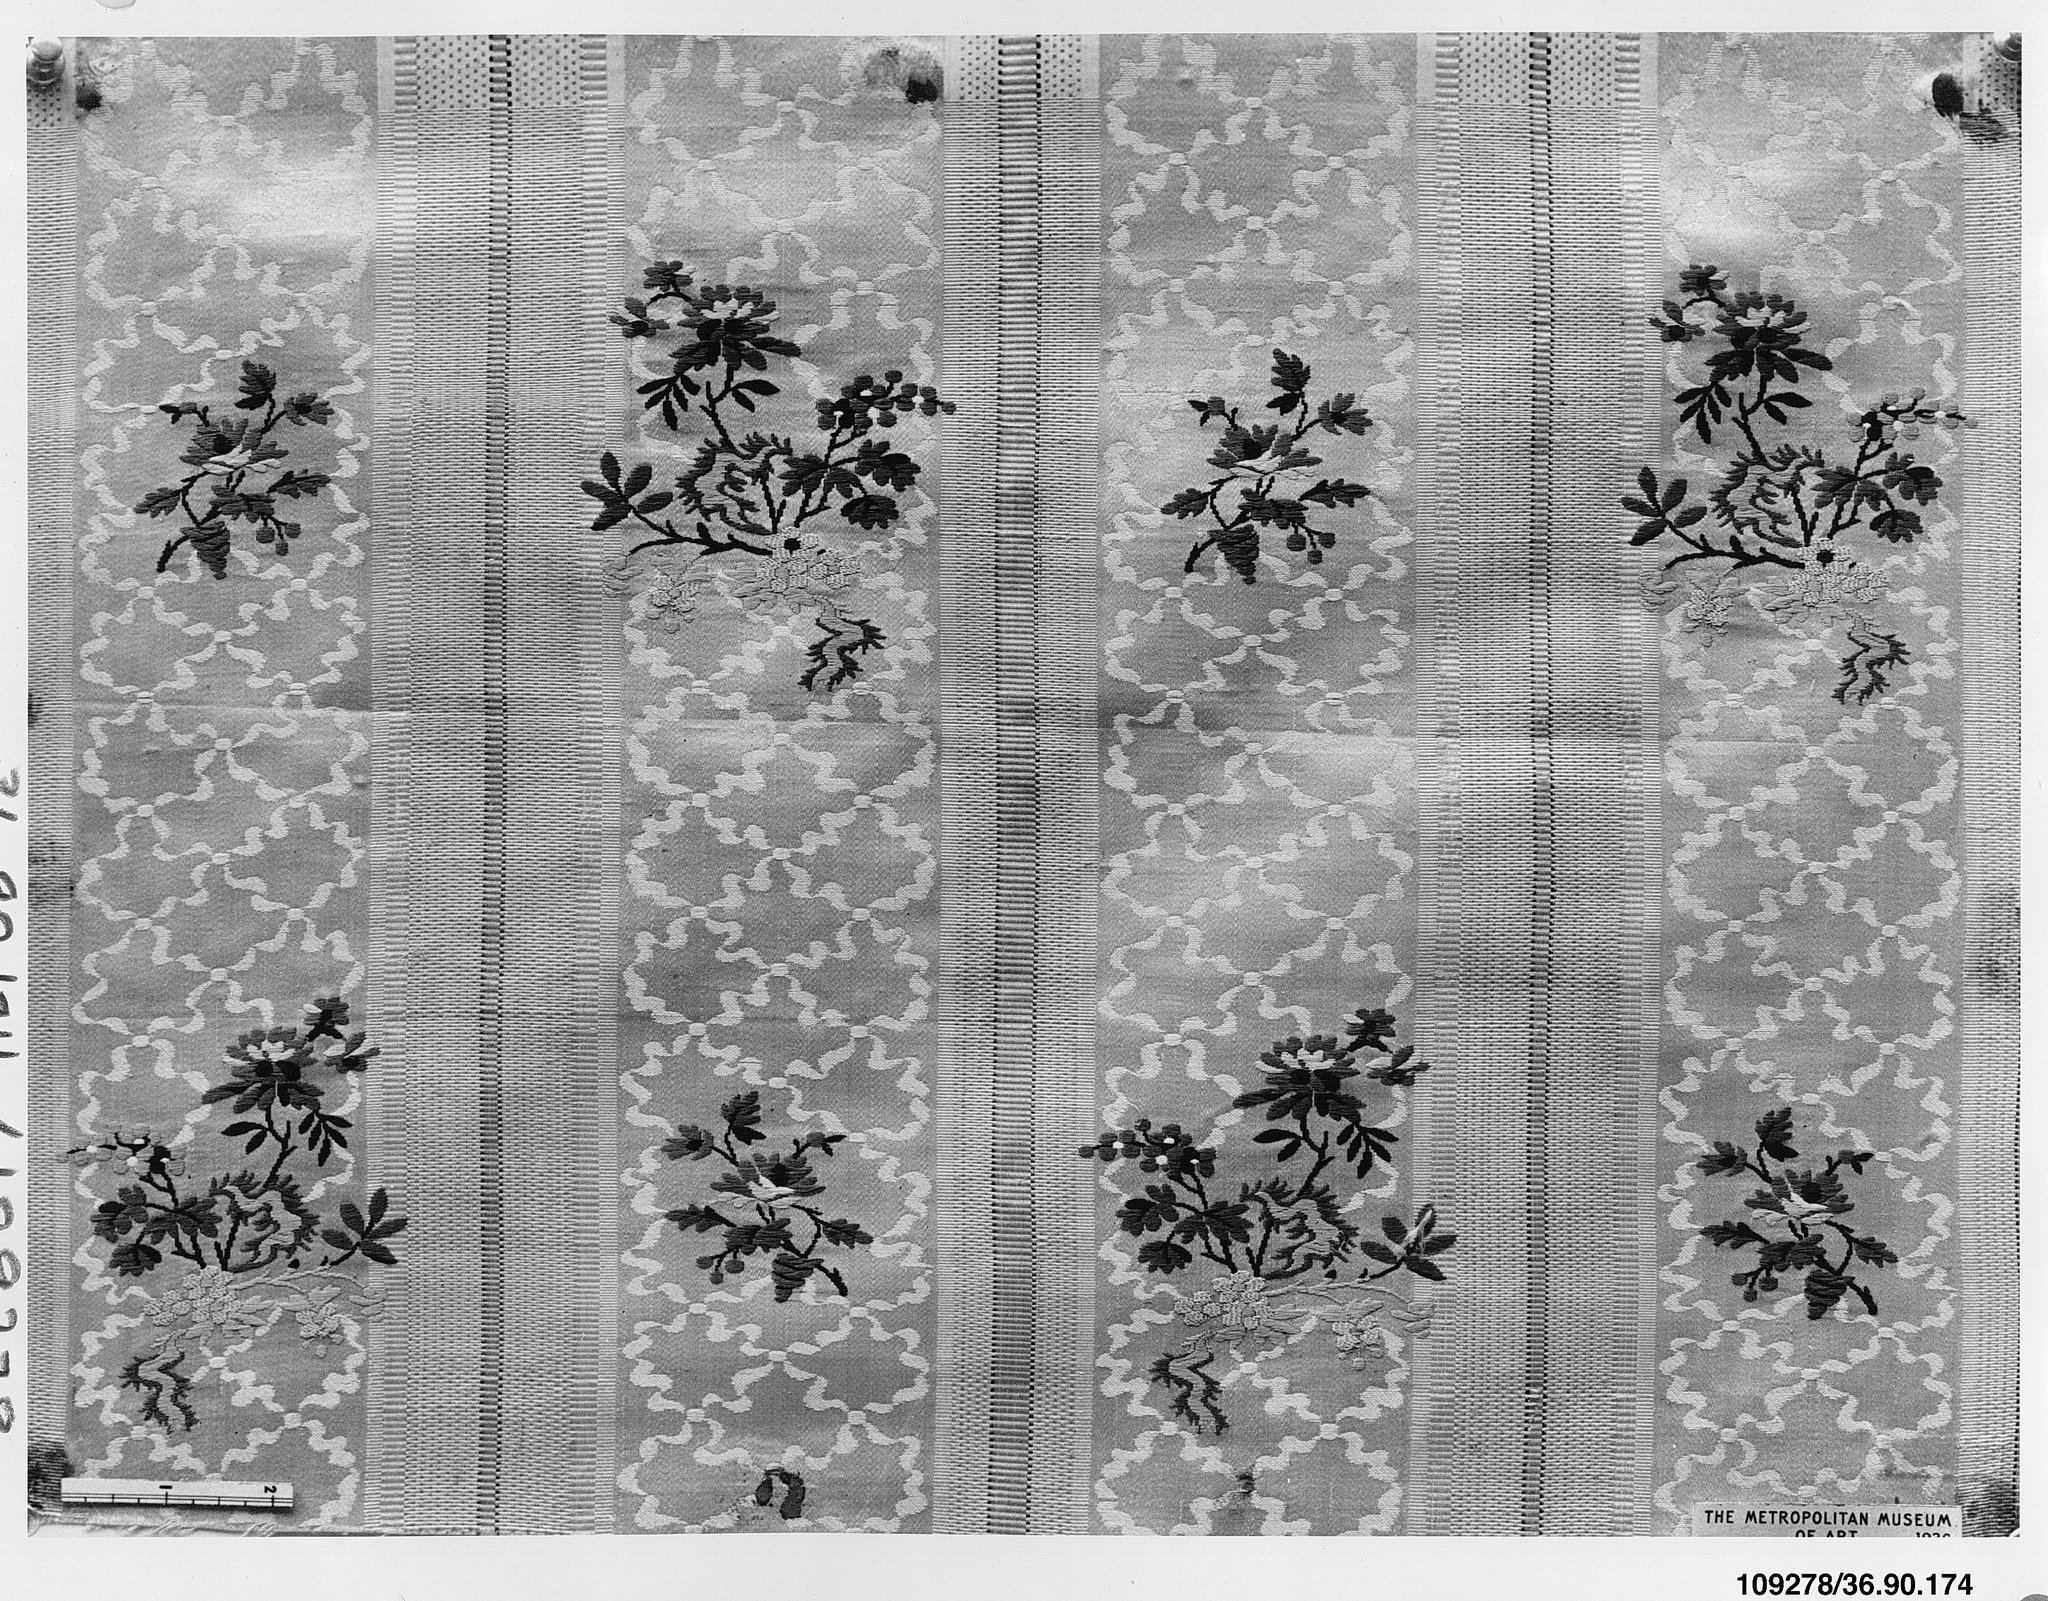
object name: piece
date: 1701-1800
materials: silk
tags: flowers,leaves